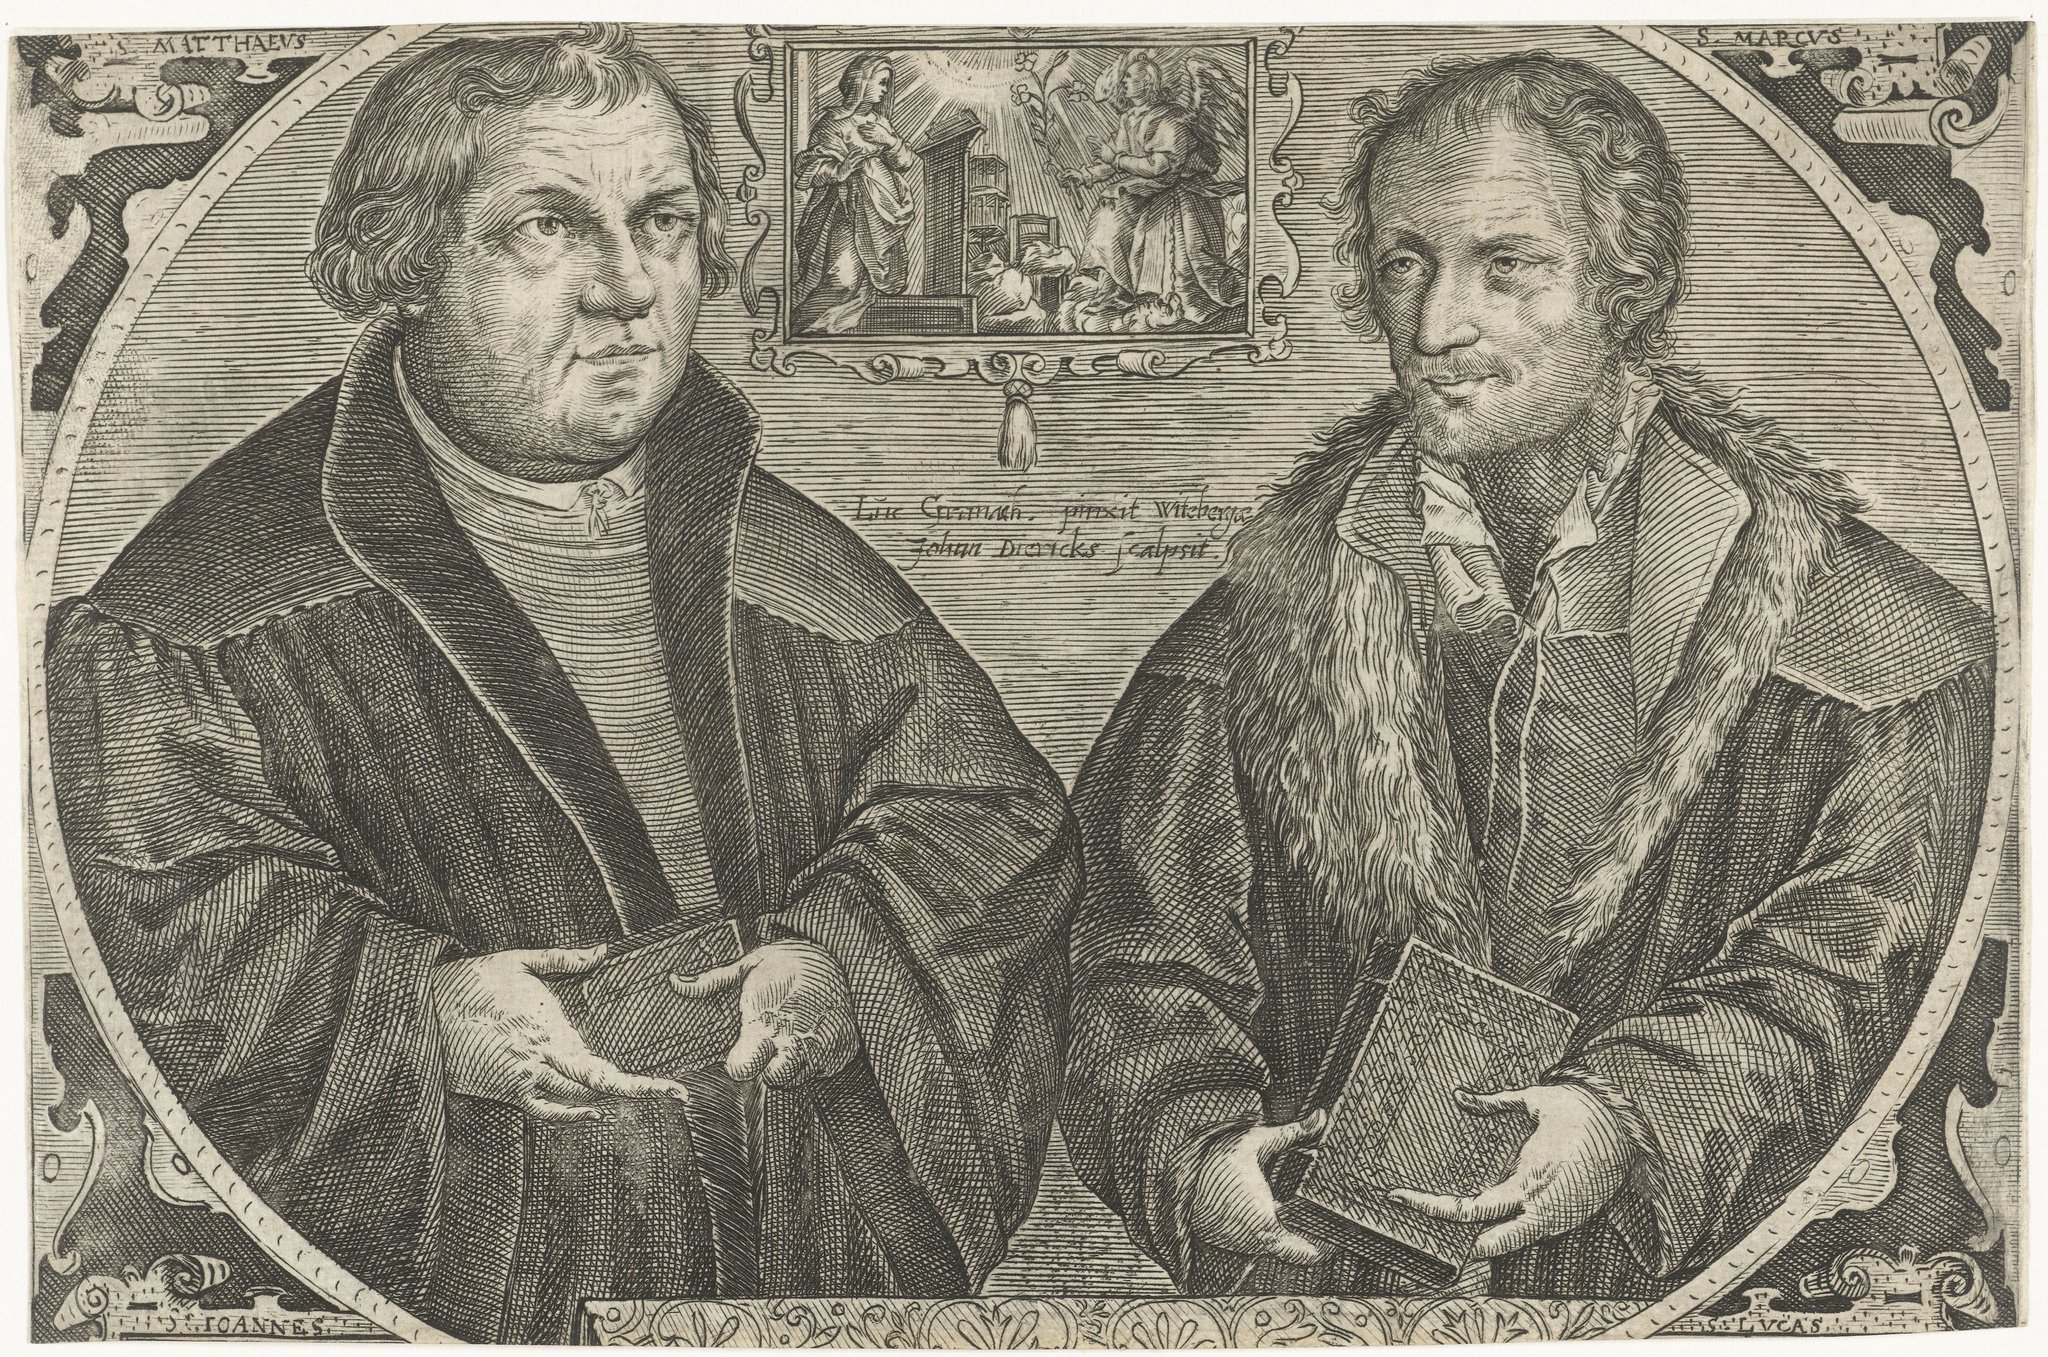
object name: print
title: Dubbelportret van Martin Luther en Philipp Melanchton met annunciatie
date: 1550-1622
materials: paper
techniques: engraving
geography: netherlands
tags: priest, martin luther, theologian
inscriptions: collector's mark: Lugt 2228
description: Dubbelportret van Luther en Melanchton, beiden in halffiguur staand met bijbel aan weerszijden van kleine cartouche met annunciatie.